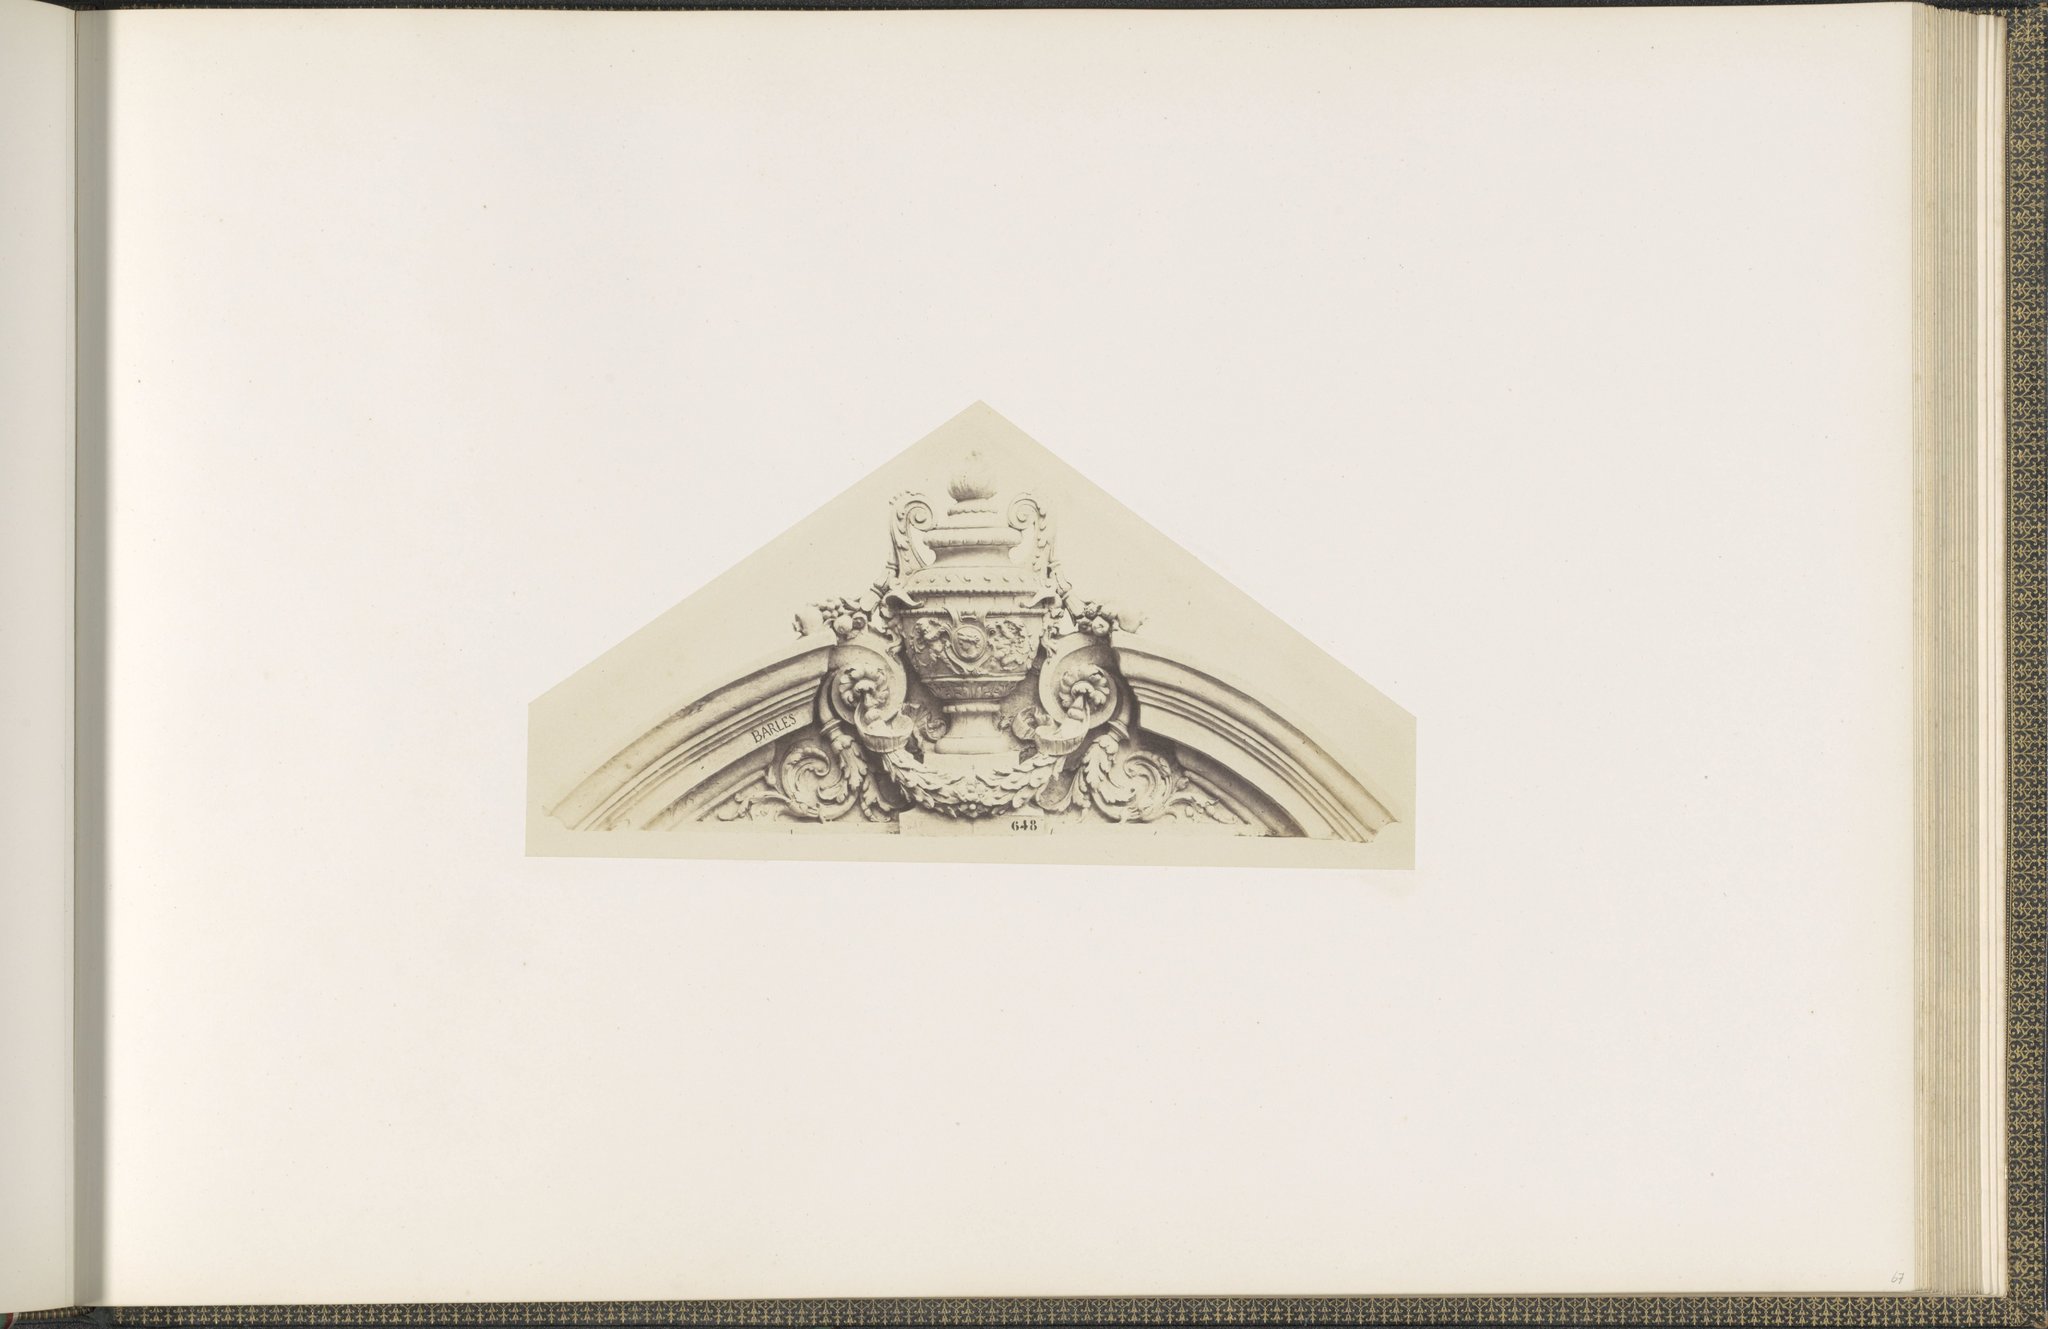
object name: photograph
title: Gipsmodel voor versiering boven een deur van het Pavillon Richelieu in het Palais du Louvre door Barles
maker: édouard denis baldus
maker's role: fotograaf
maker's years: 1813-1889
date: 1855-1857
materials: paper, photographic support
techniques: salted paper print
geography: paris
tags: permanent exhibition, museum, ornamenting, decorating ~ applied arts, paris, tuileries palace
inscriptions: number: ‘648’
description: Onderdeel van Réunion des Tuileries au Louvre 1852-1857, album 4.